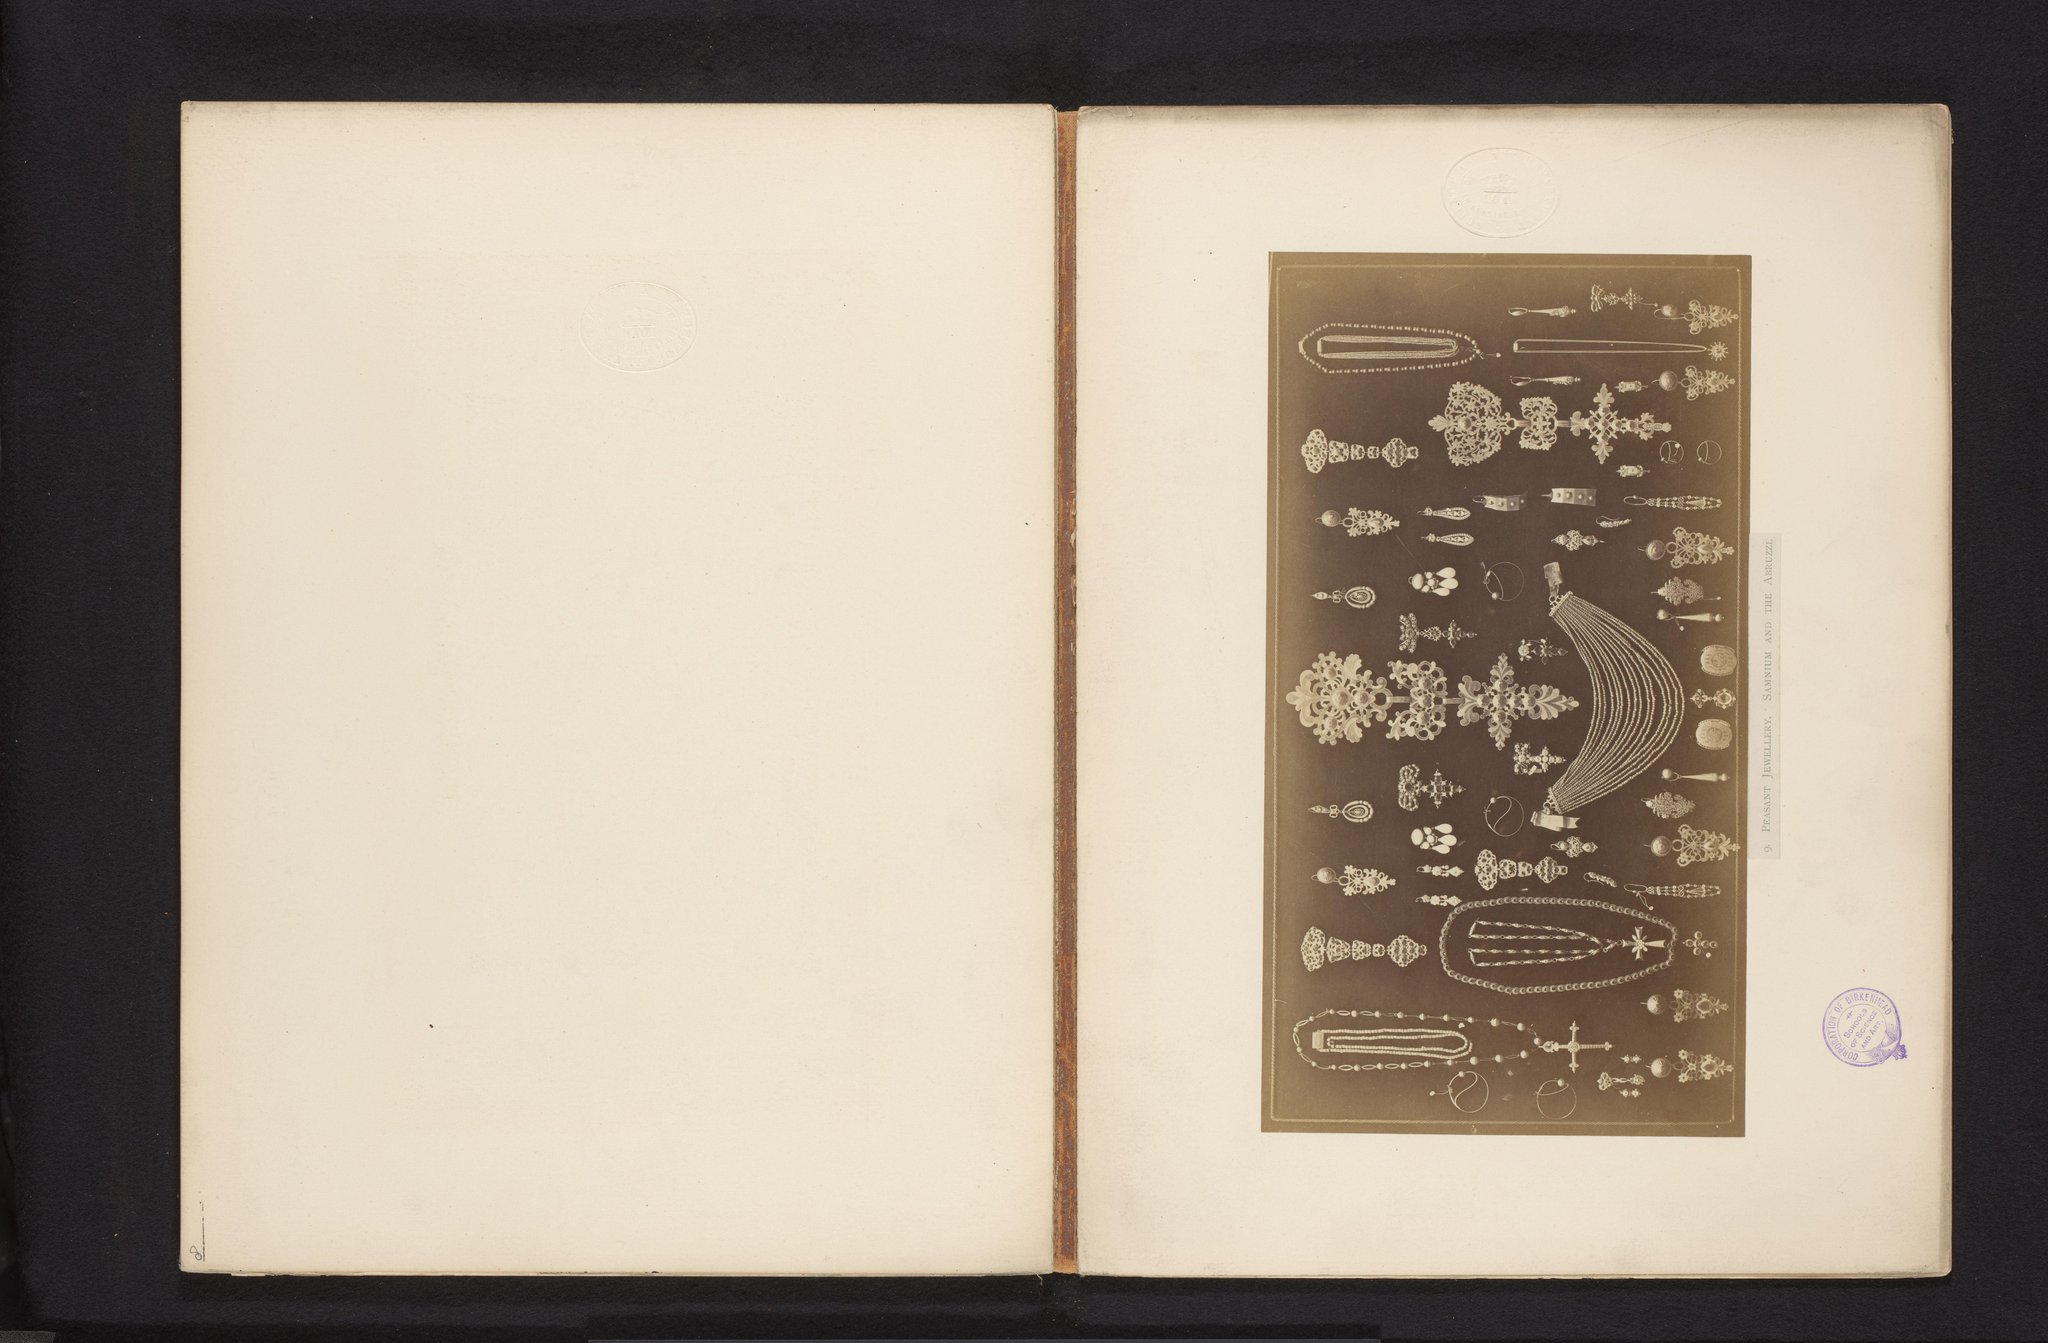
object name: photograph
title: Sieraden uit de regio van Samnium en Abruzzo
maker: Anonymous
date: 1863-1868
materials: photographic support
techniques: albumen print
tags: ornaments, jewels, necklace, ear-rings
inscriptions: collector's mark: ‘South Kensington/ Science and art department’, collector's mark: ‘Corporation of Birkenhead/ schools of science and art’